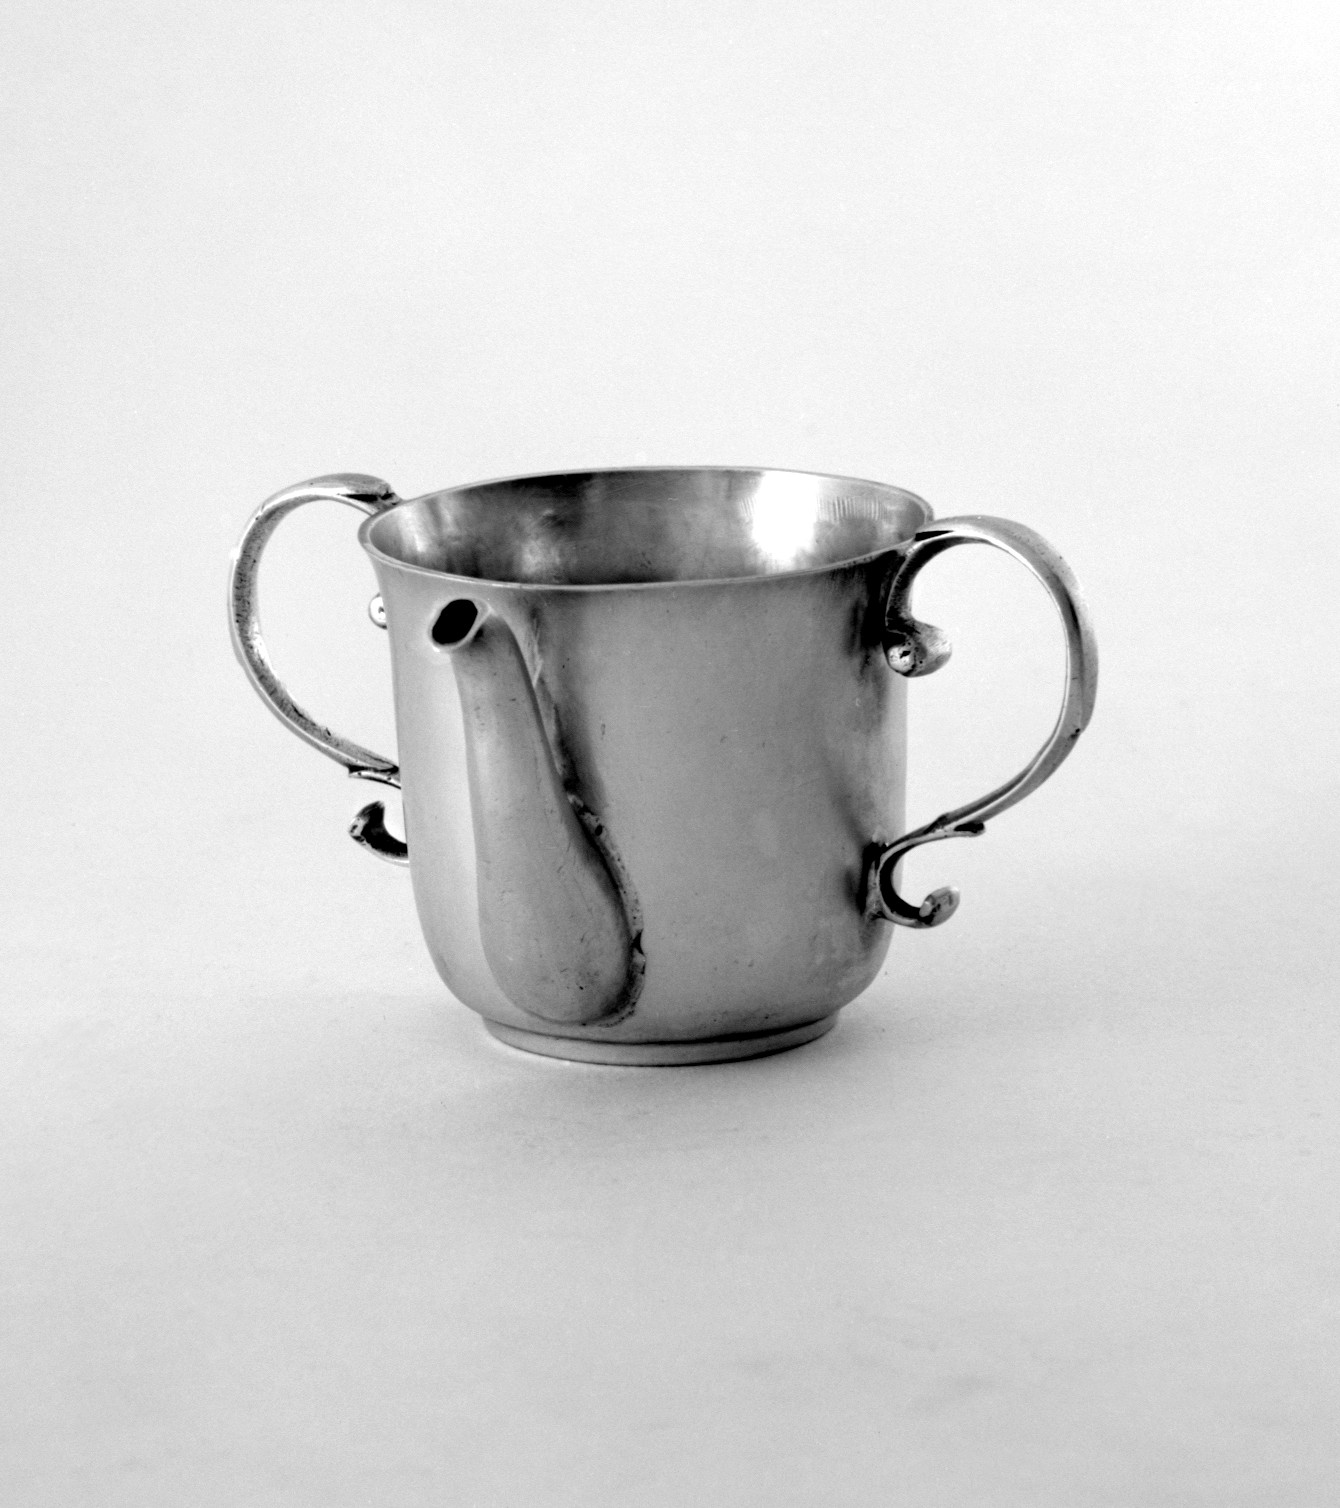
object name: cup, feeding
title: Feeding cup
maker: thomas holland i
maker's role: maker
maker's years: 1707-1718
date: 1707-1708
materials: silver